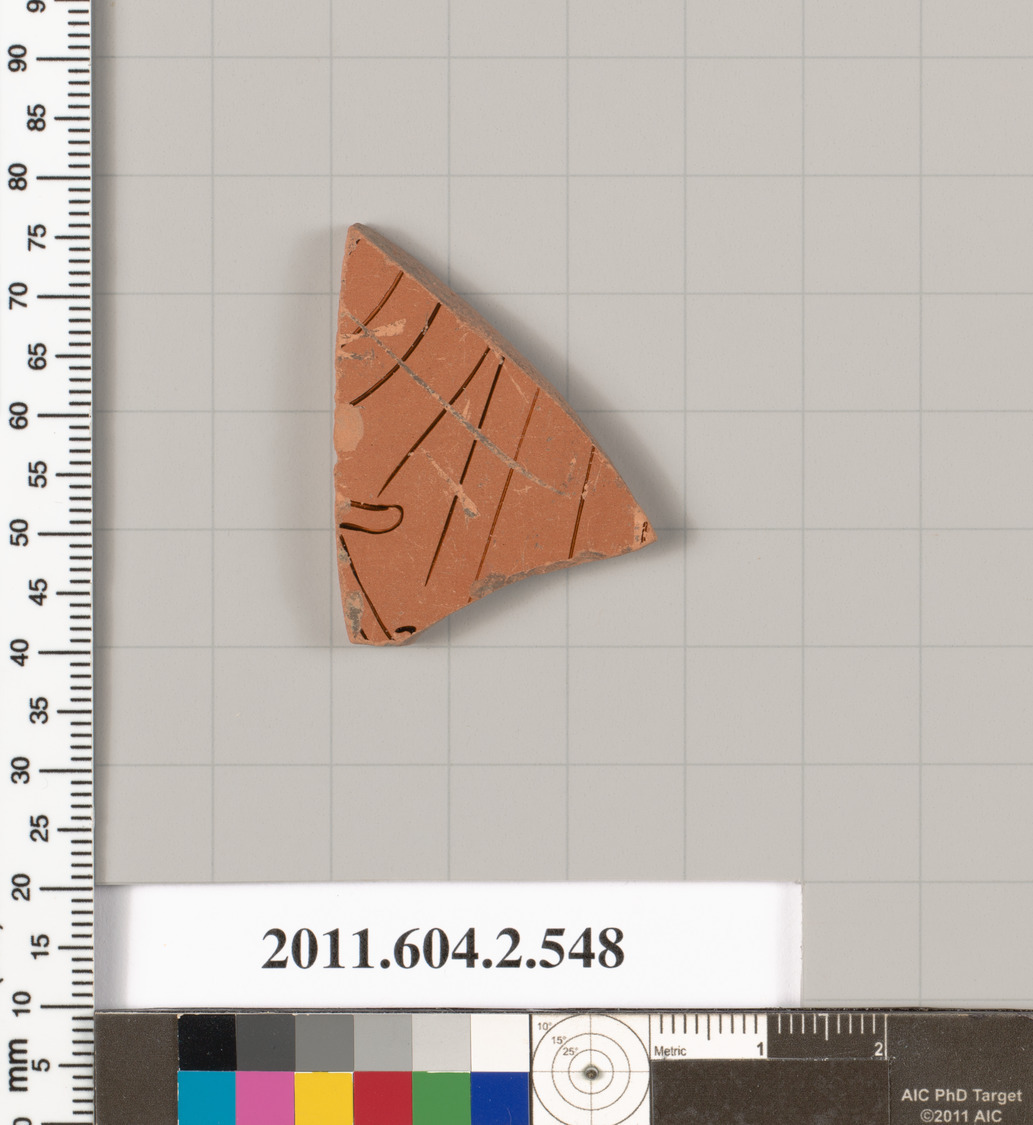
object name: column krater fragment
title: Terracotta fragment of a column-krater (bowl for mixing wine and water)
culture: greek, attic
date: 460-440 BCE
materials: terracotta